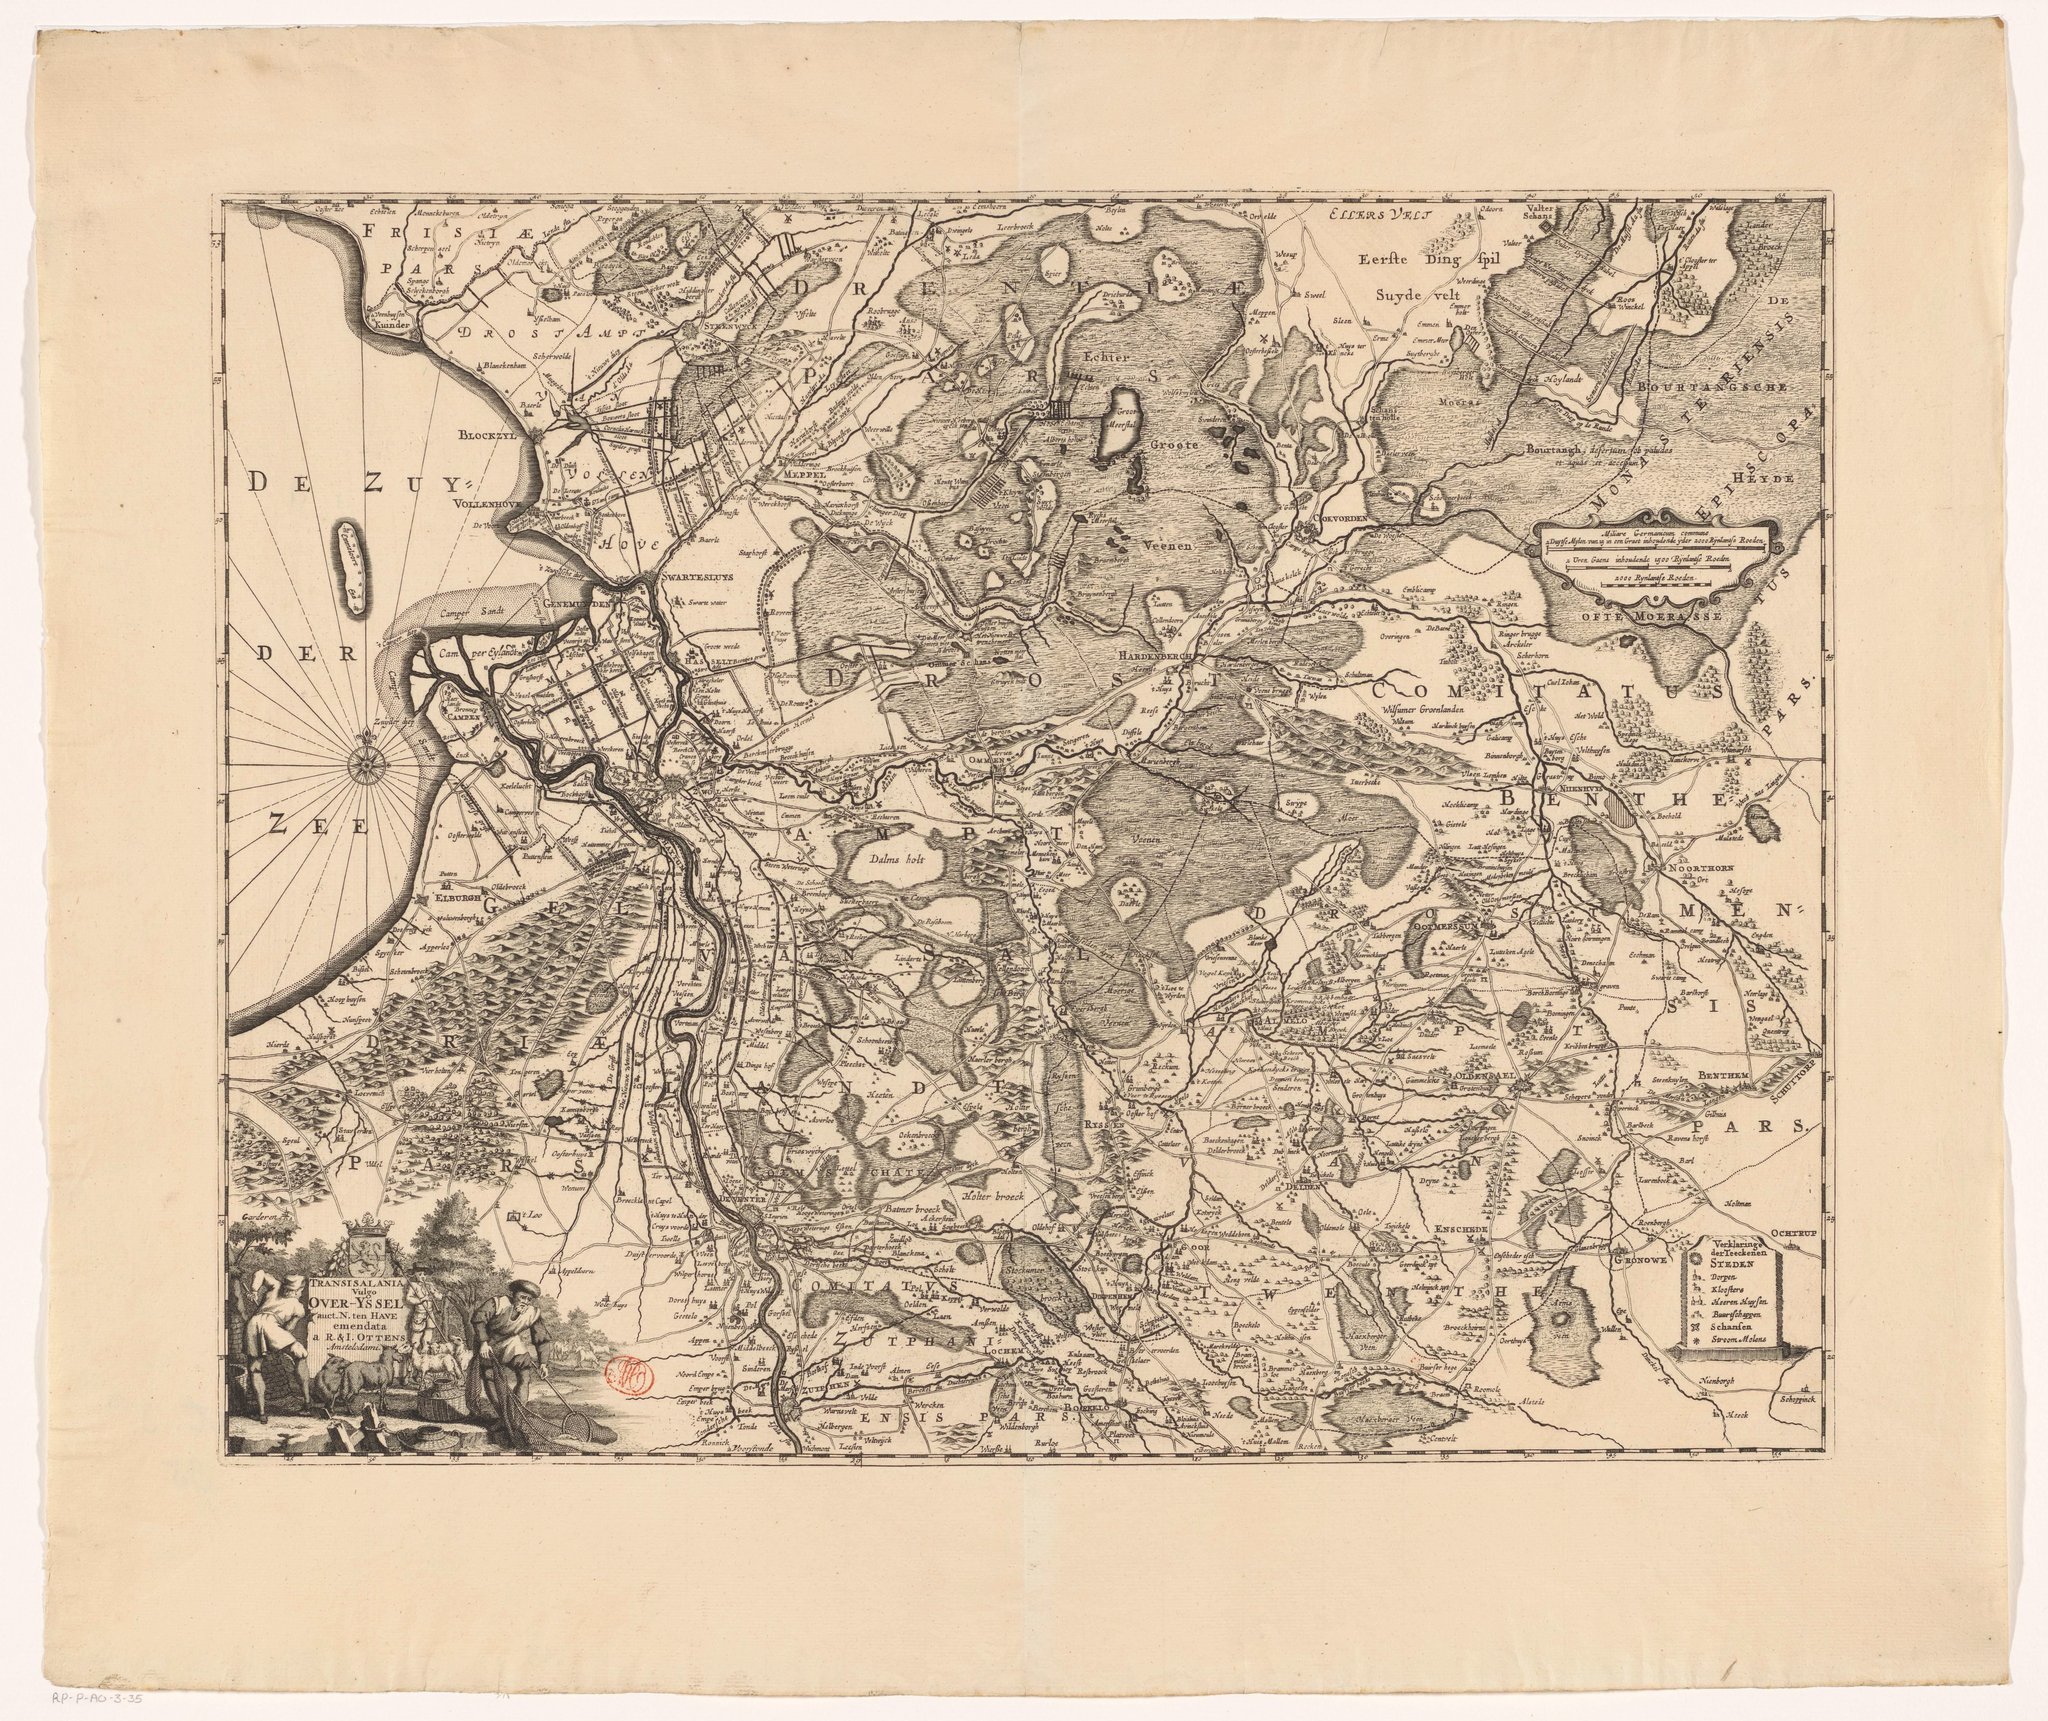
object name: map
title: Kaart van Overijssel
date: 1726-1750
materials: paper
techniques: engraving, etching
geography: amsterdam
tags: coat of arms (as symbol of the state, etc.), peat-cutting, maps of separate countries or regions, herding, herdsman, herdswoman, shepherd, shepherdess, cowherd, etc., fisherman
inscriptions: collector's mark: Lugt 195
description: Linksonder cartouche met titel en het wapen van Overijssel. Daaromheen een turfsteker, een herder en een visser. Rechtsboven drie schaalstokken: Miliare Germanicum commune / 2 Duytse mylen van 15 in een graet inhoudende ijder 2000 Rijnlantse roeden, 2 uren gaens inhoudende 1500 Rijnlantse roeden, 2000 Rynlantse roeden. Rechtsonder een legenda. Gradenverdeling langs de randen.